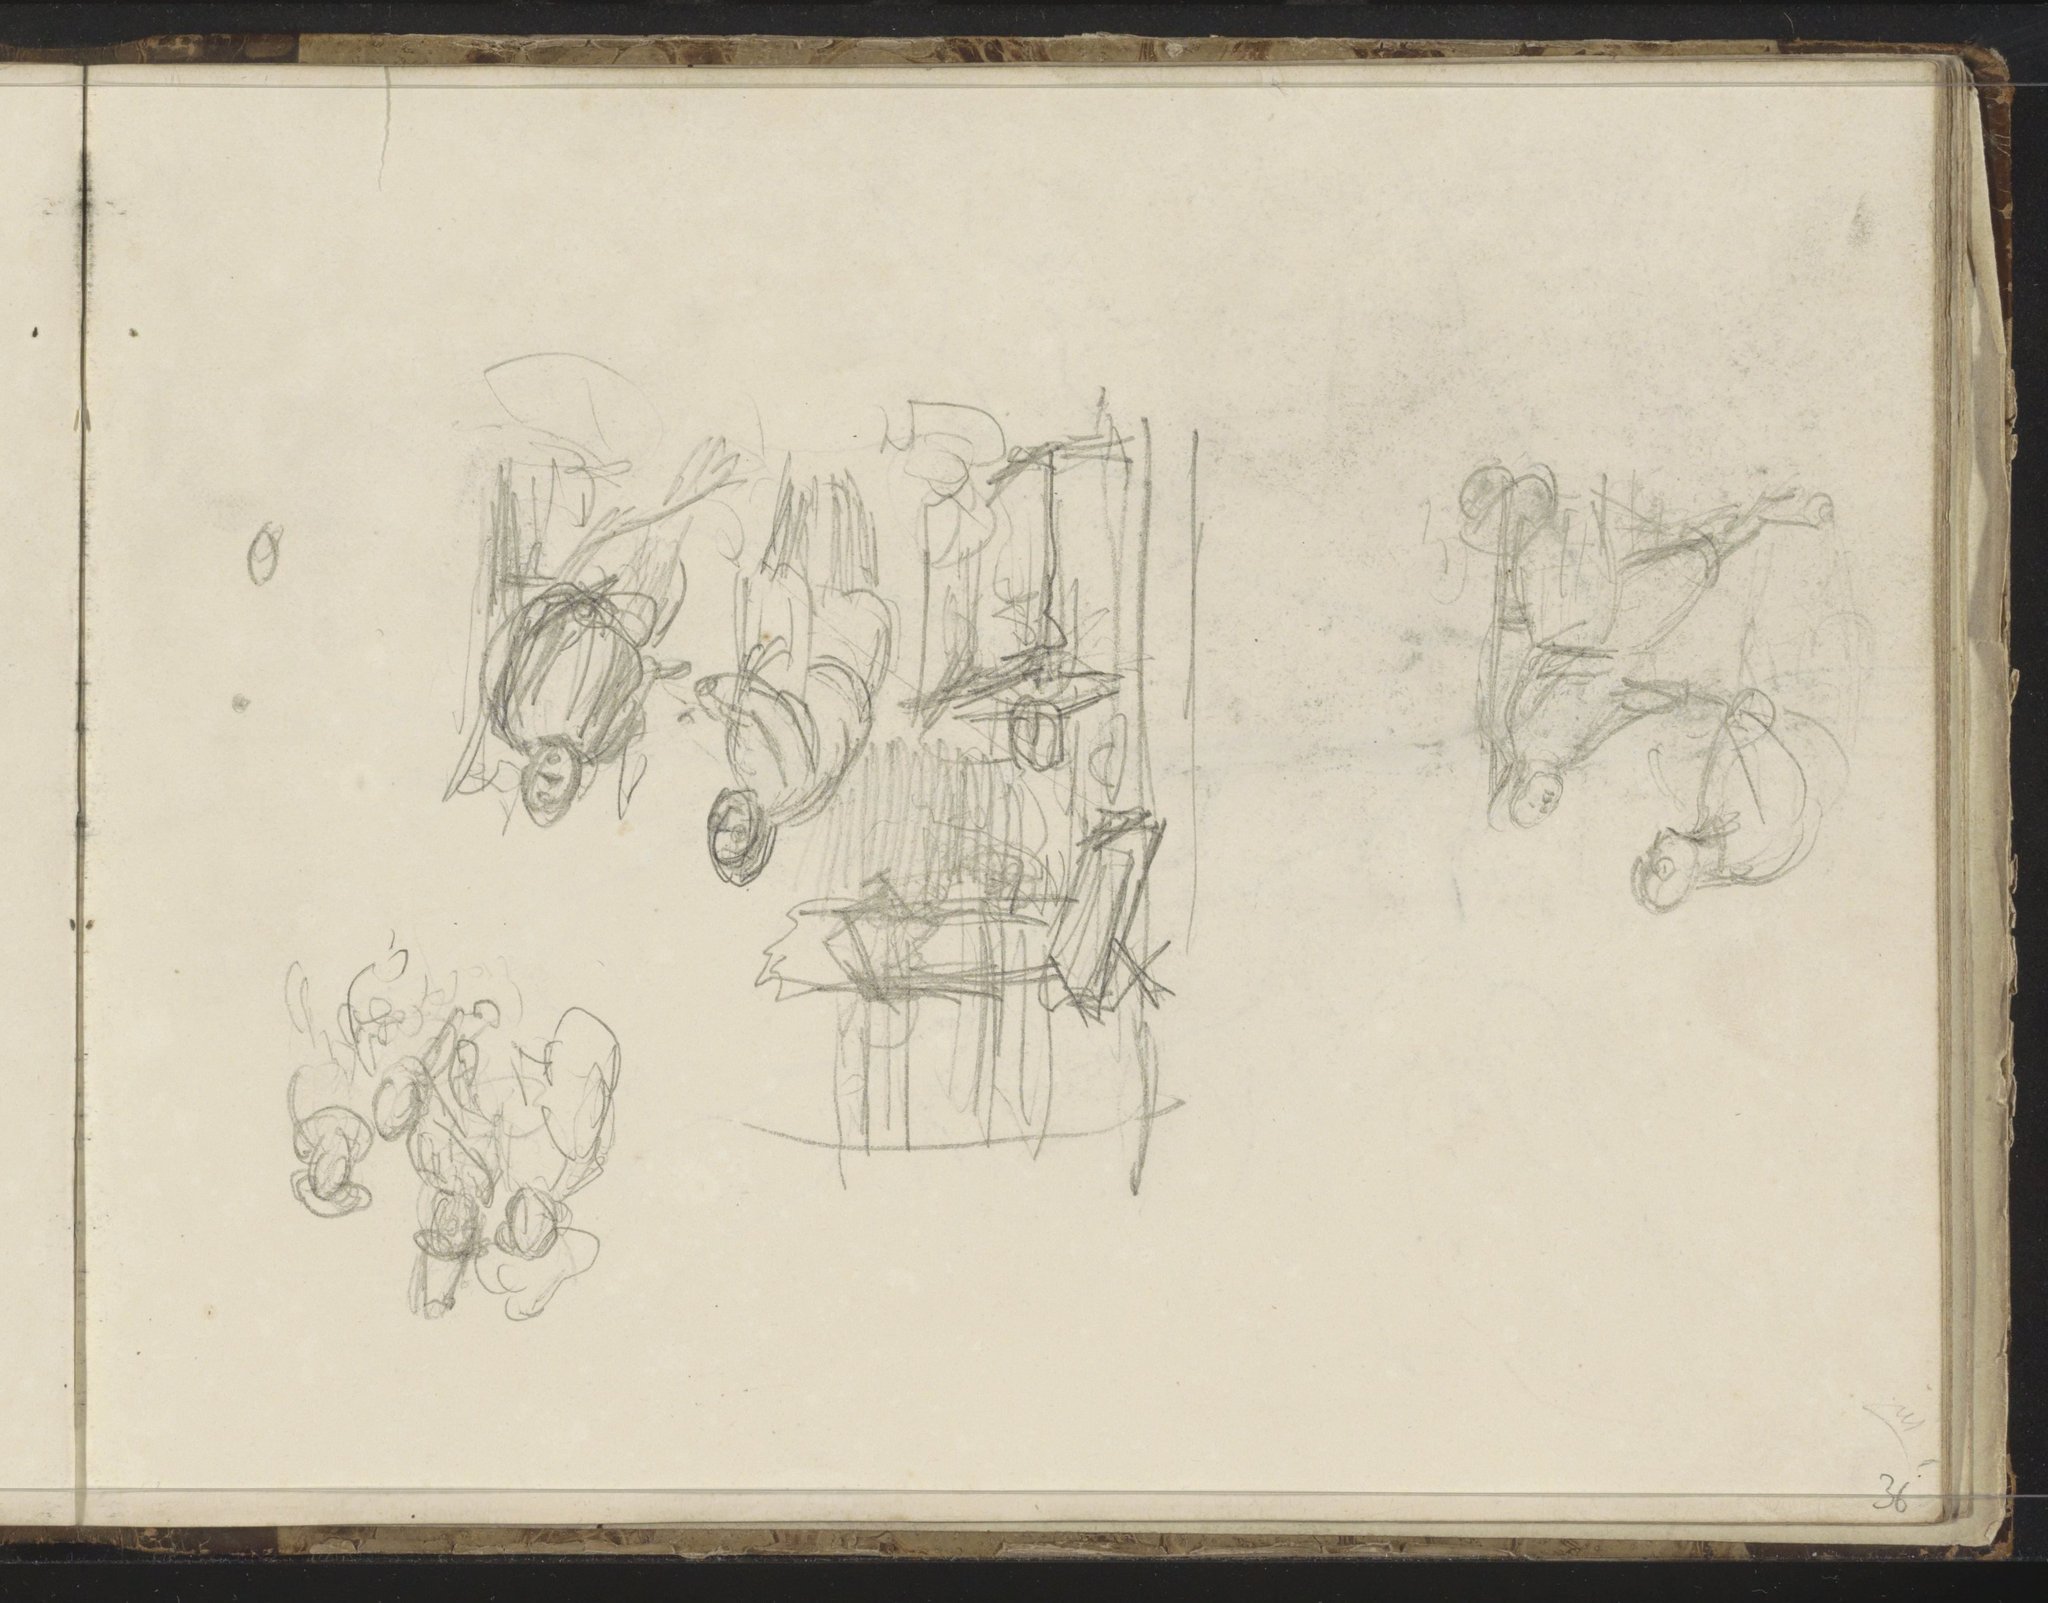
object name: sketchbook leaf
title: Figuurstudies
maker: willem hendrik schmidt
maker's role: draughtsman, painter, print maker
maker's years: 1809-1849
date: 1819-1849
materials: paper, pencil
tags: anatomy (non-medical), family, relationship, descent, interior of the house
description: Studie van een gezin en van twee figuren in een interieur. Blad 36 recto uit een schetsboek met 52 bladen.